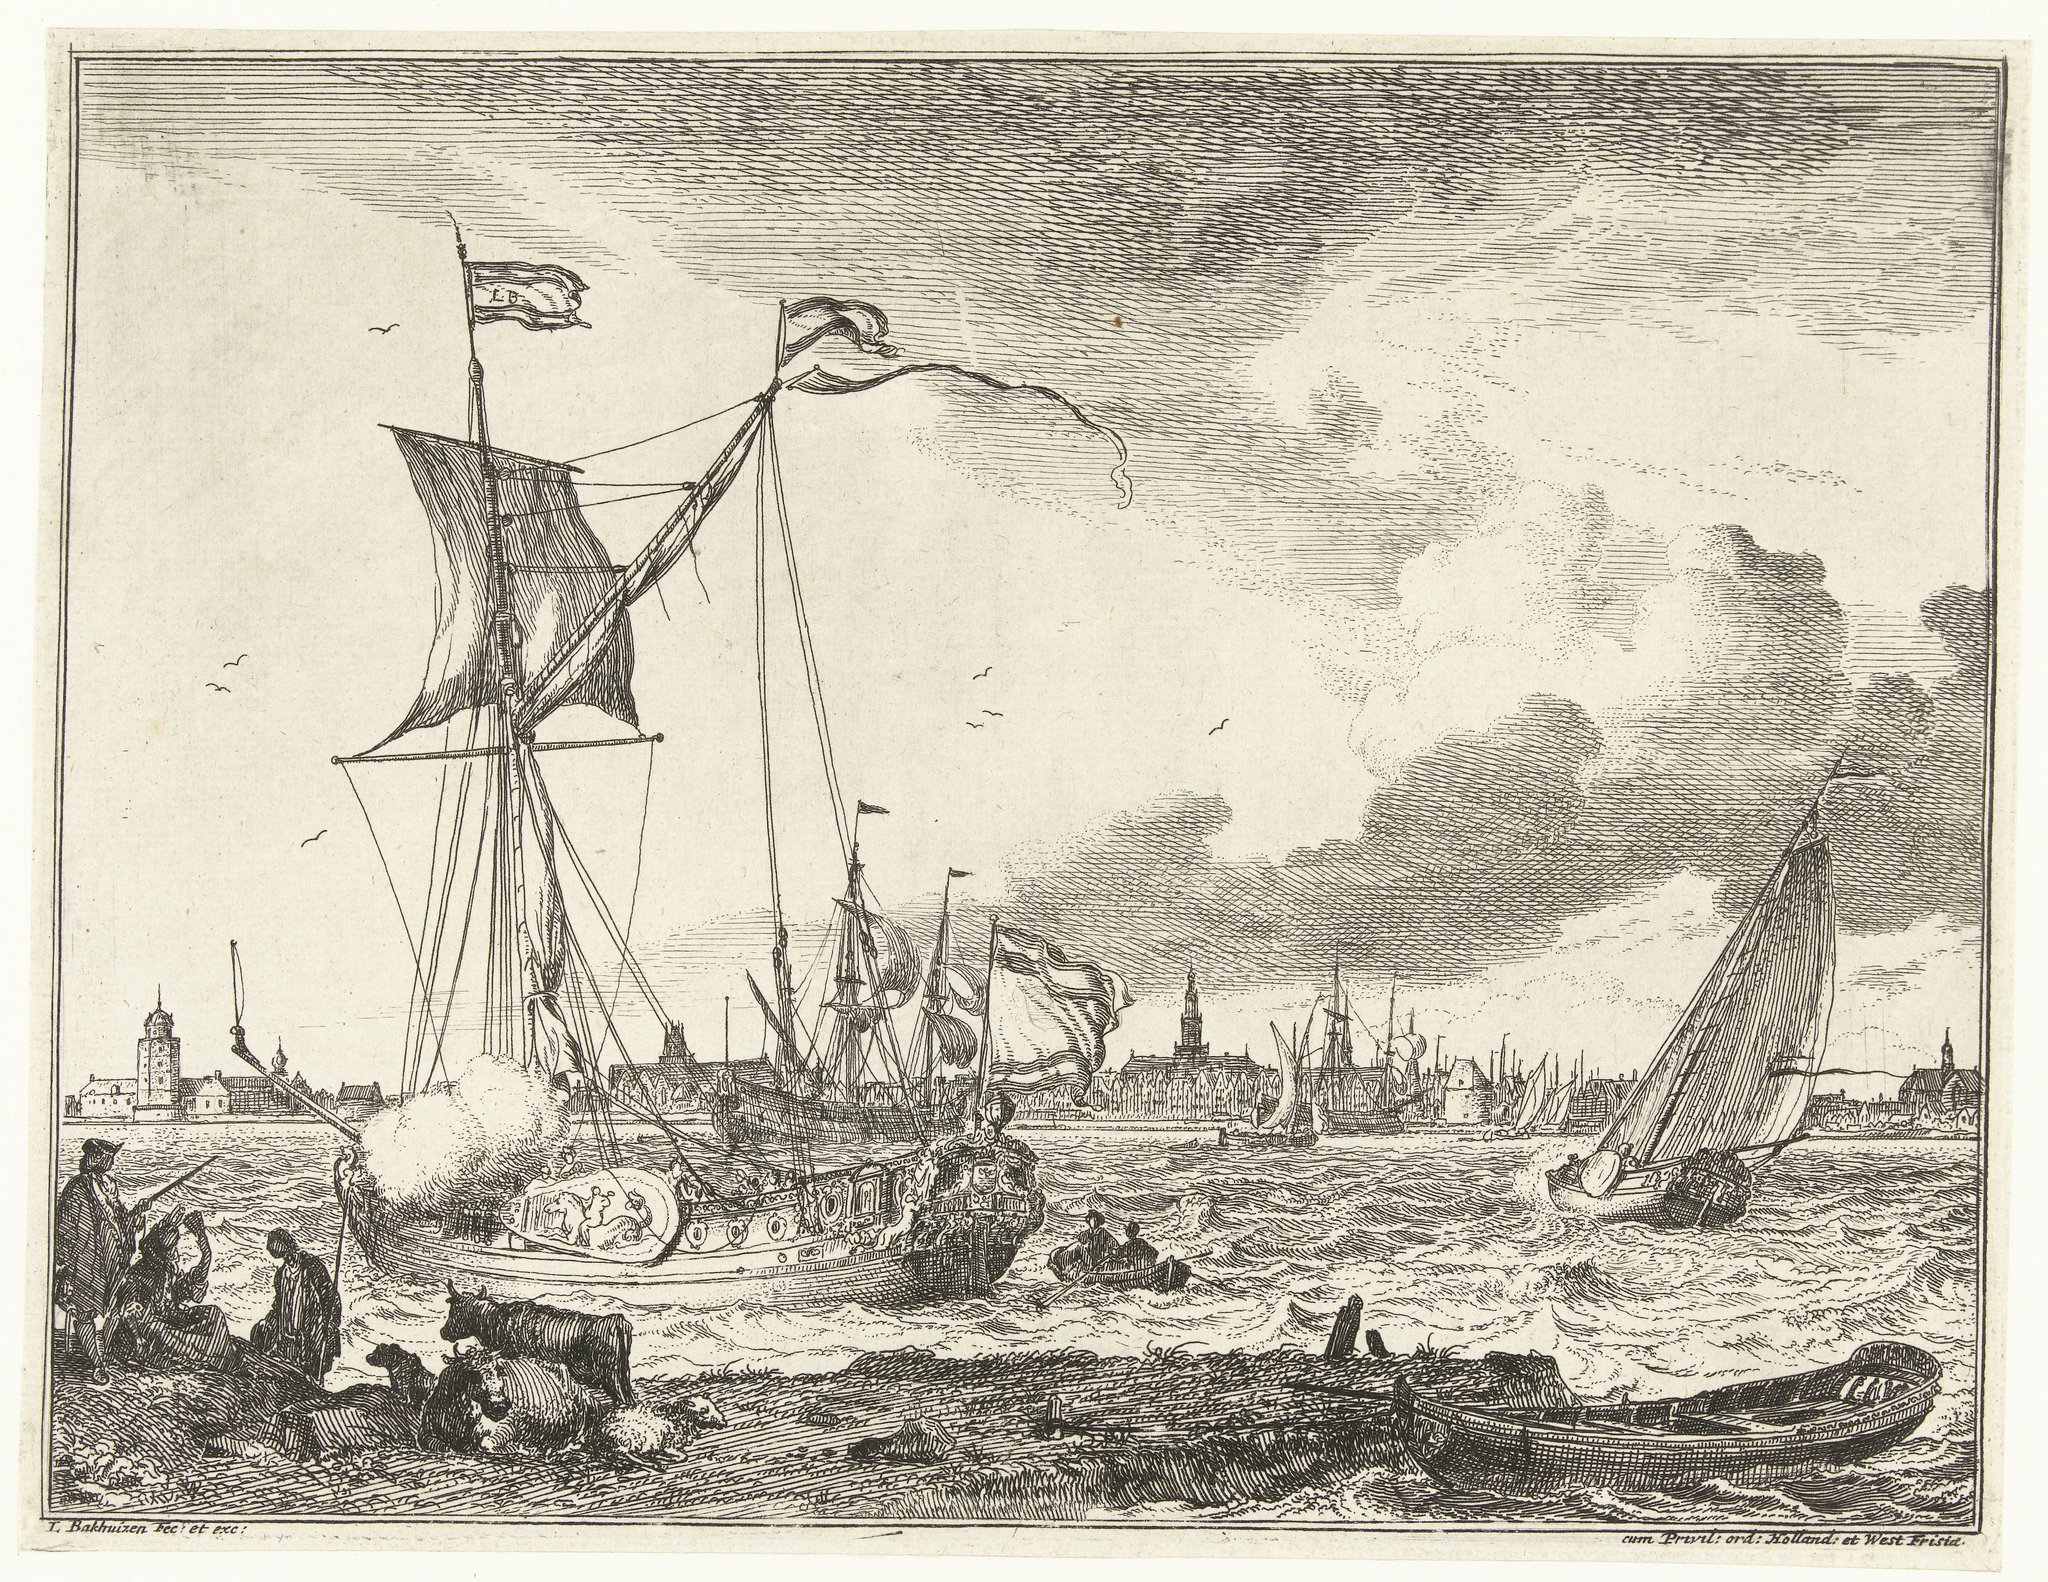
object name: print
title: Zeegezichten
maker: ludolf bakhuysen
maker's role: draughtsman, print maker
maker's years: 1631-1708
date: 1701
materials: paper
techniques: etching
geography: amsterdam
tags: landscapes with waters, waterscapes, seascapes (in the temperate zone)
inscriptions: collector's mark: Lugt 2228, inscription: ‘F Rechberger 1800’ Lugt 2133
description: Rivieroever met grazende dieren, aan de overkant van het water ligt een stad. Prent uit een serie met tien zeegezichten.